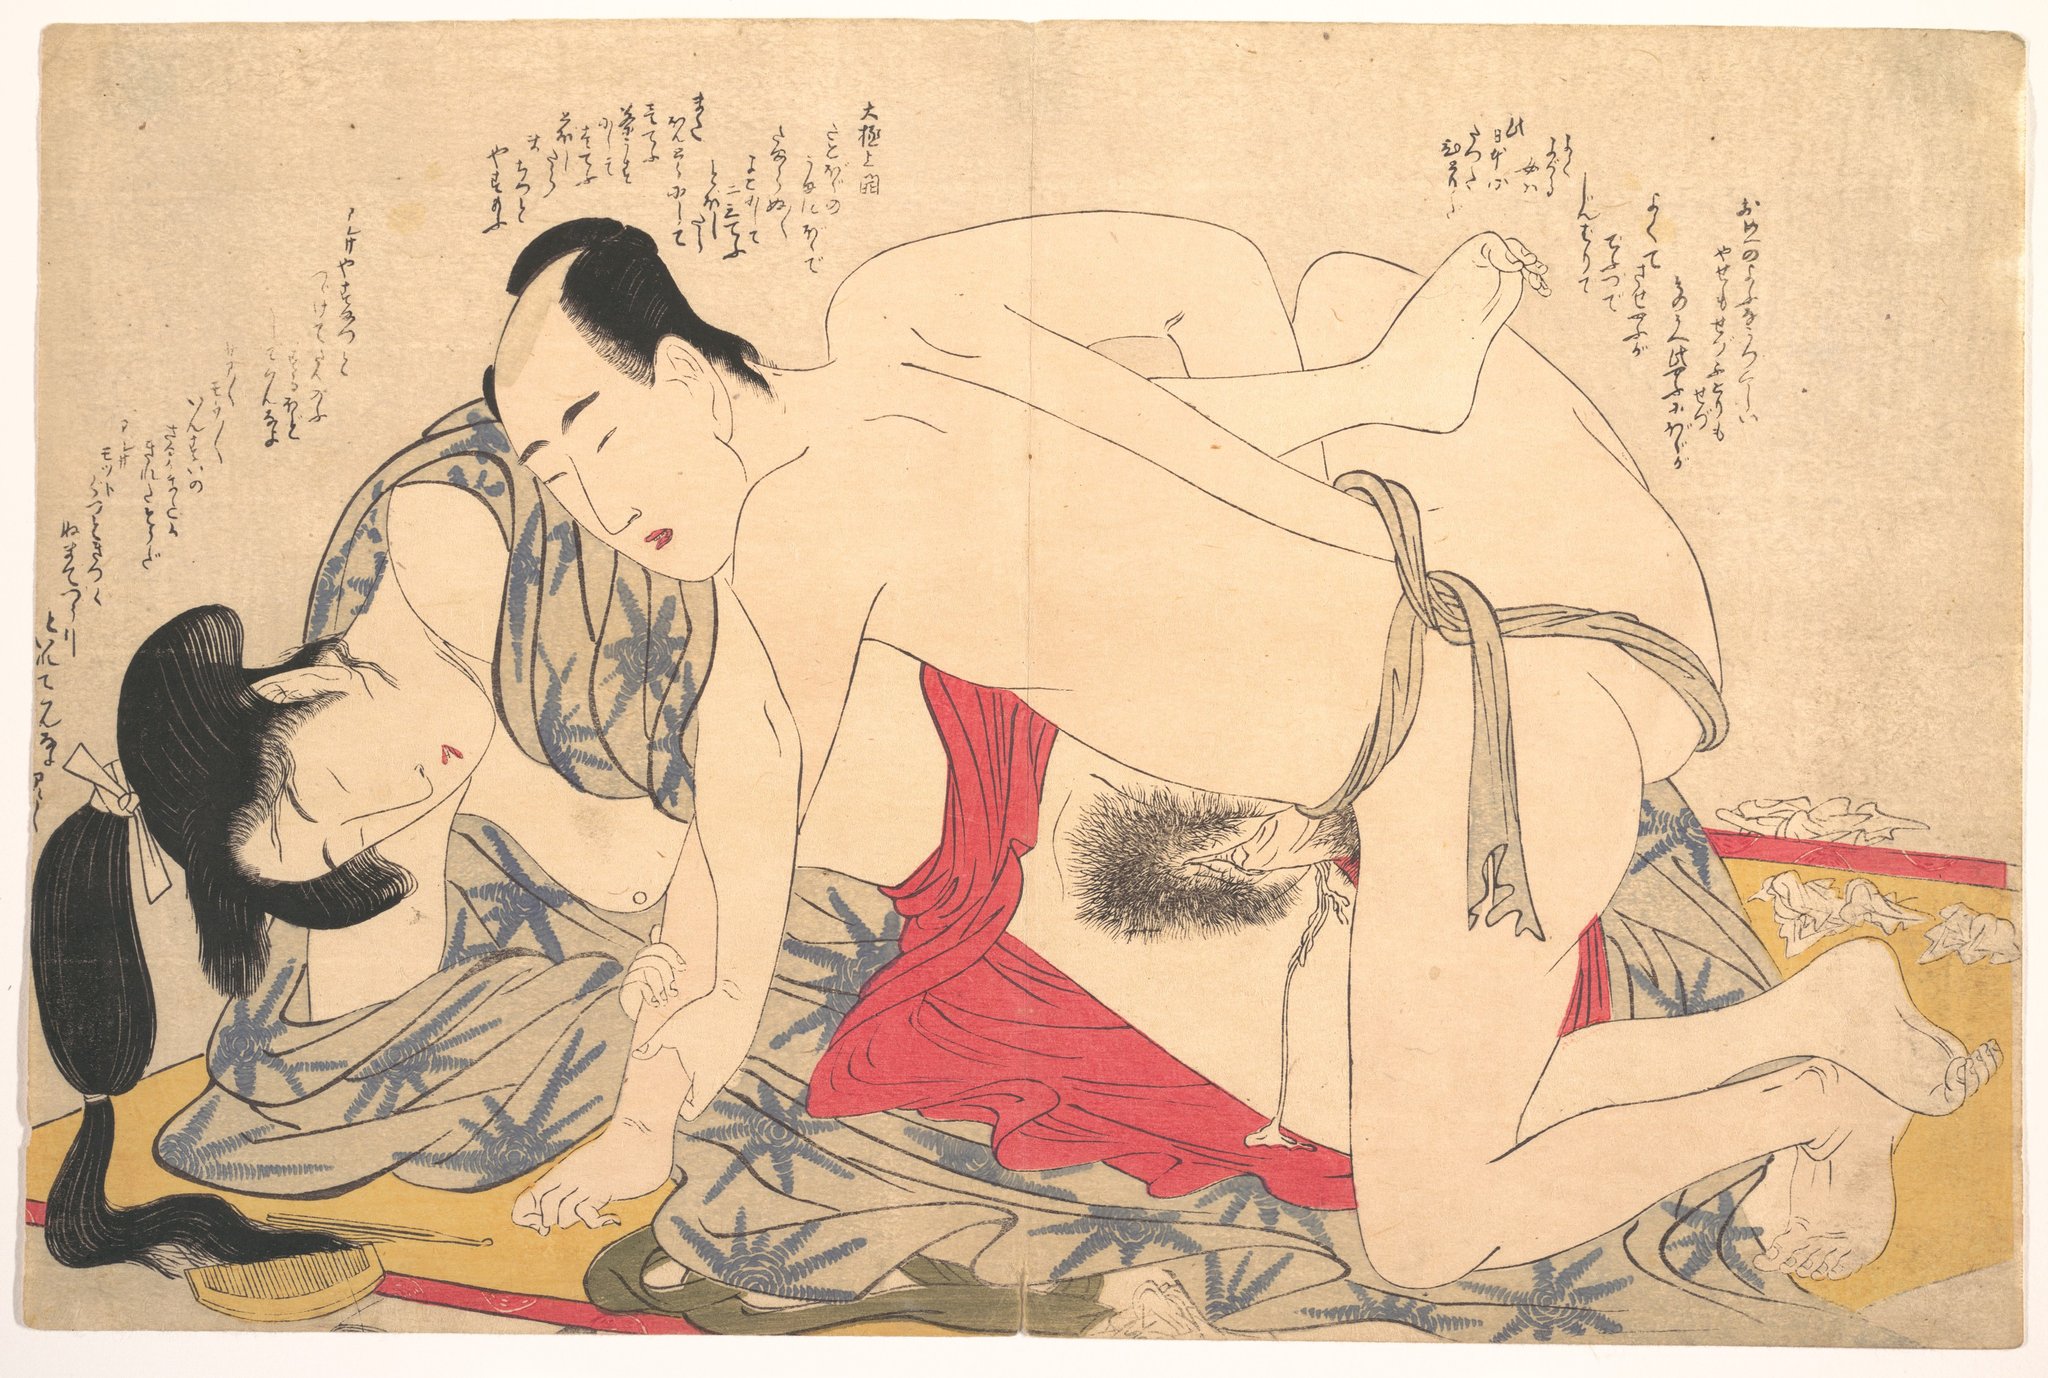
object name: print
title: Erotic Print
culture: japanese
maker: kitagawa utamaro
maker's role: artist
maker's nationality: japanese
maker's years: 1754-1806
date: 1753-1806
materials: ink, paper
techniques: woodblock print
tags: male nudes,female nudes